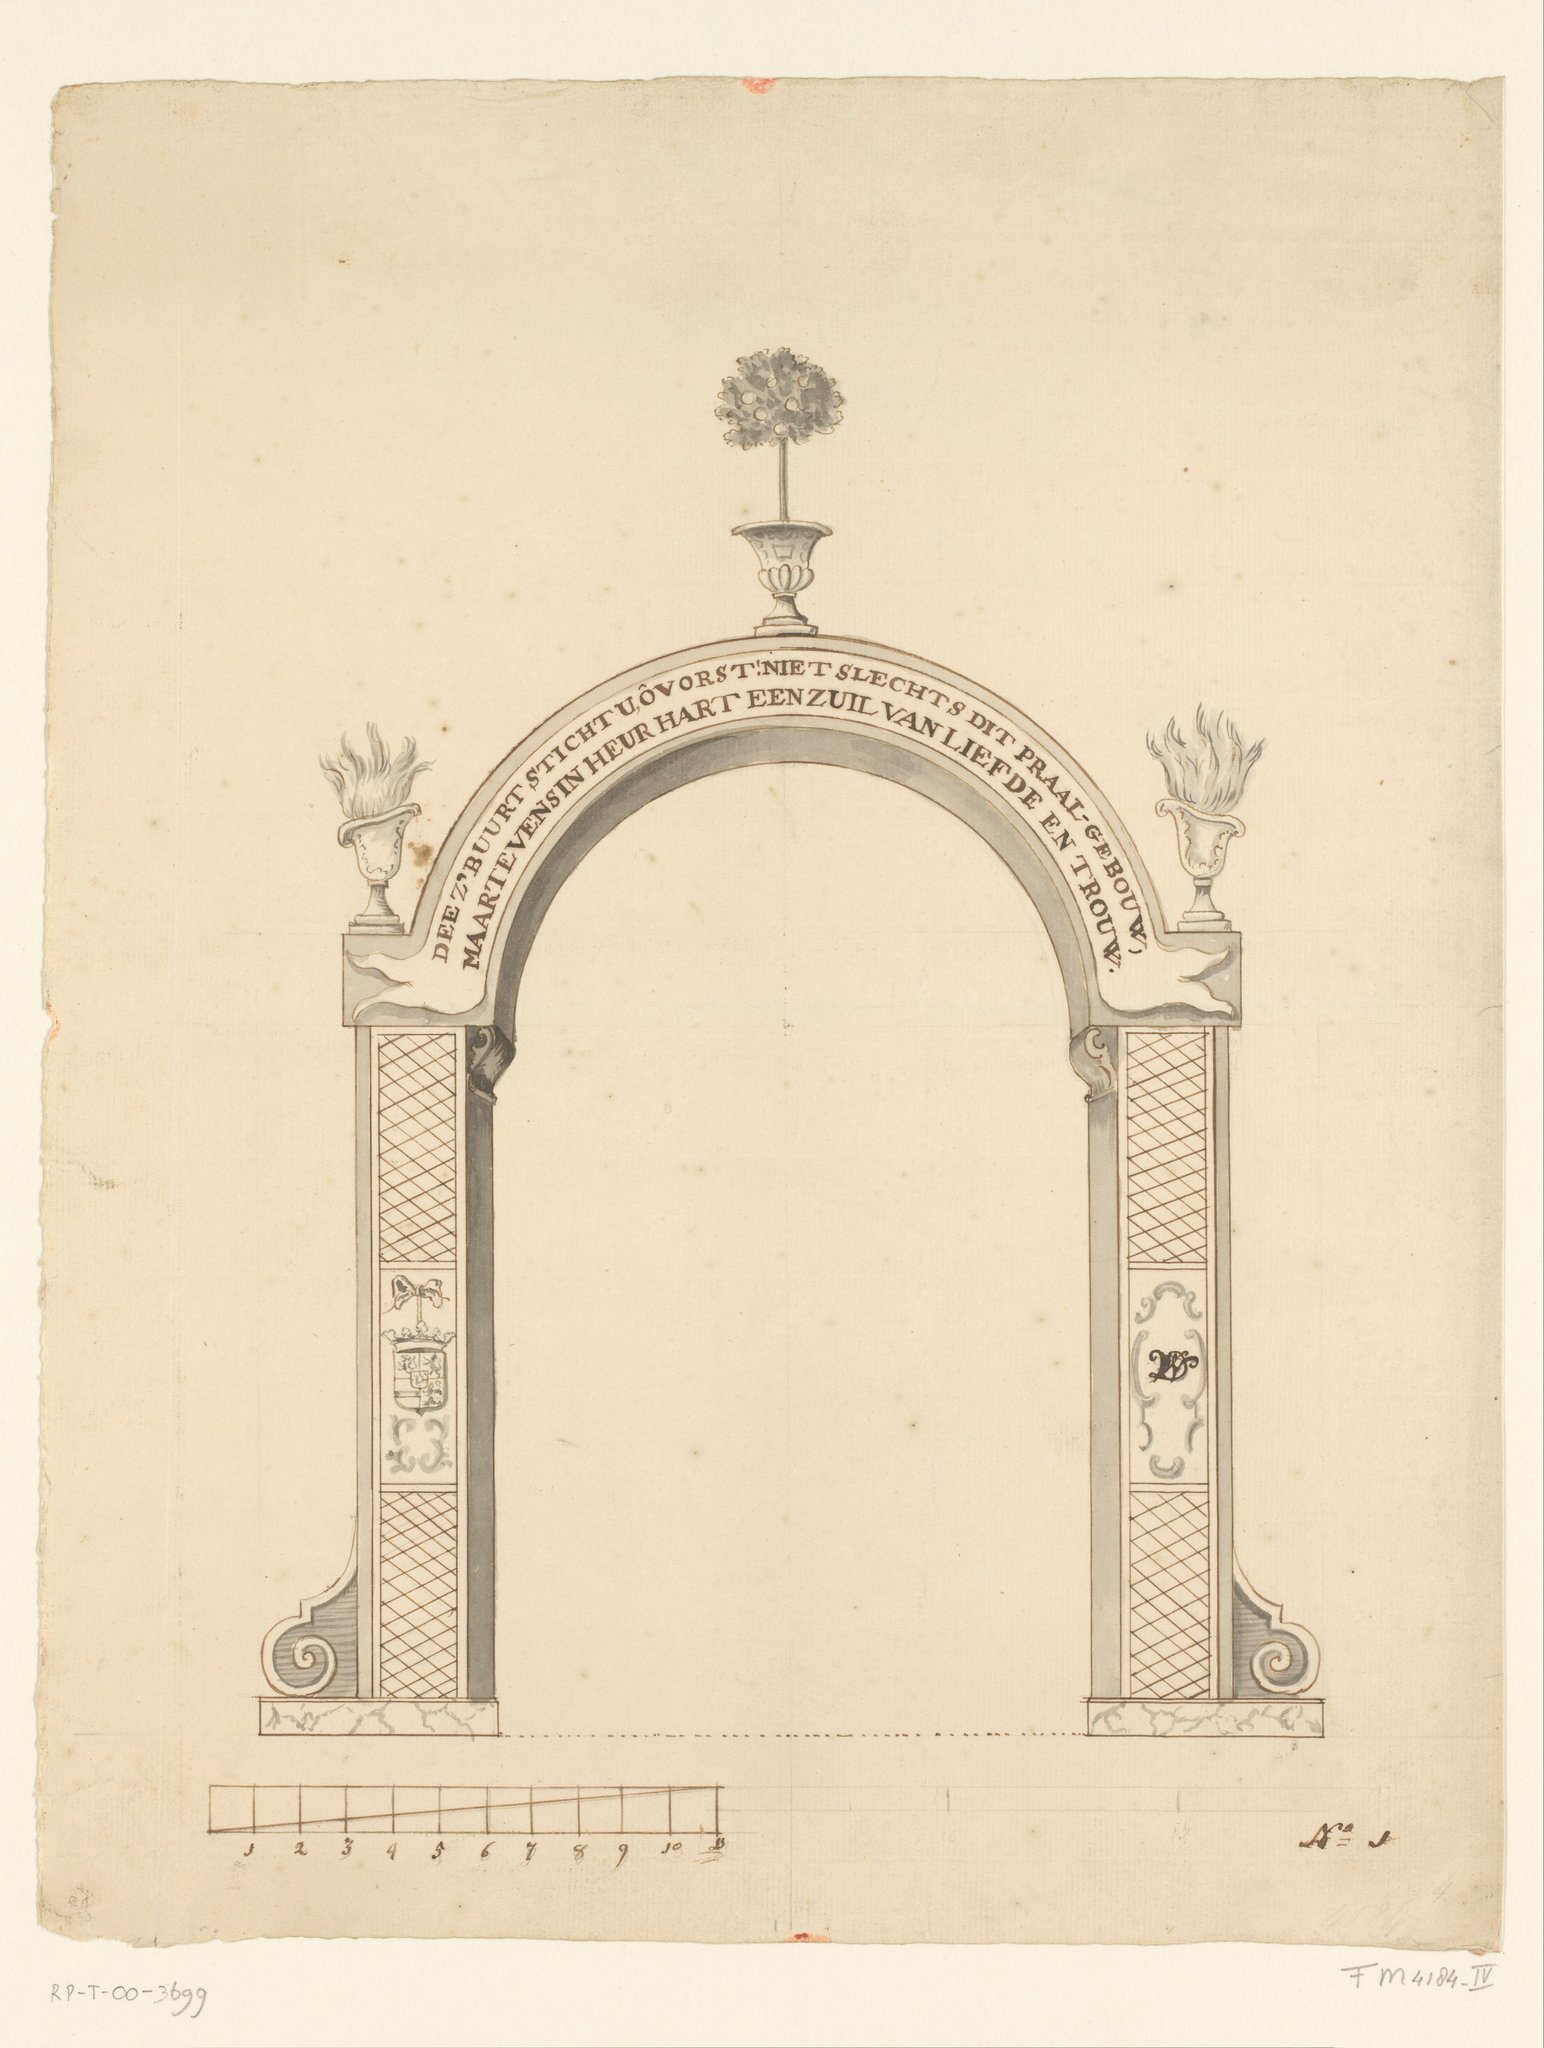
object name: drawing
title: Erepoort te Vlissingen, 1766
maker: Anonymous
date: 1766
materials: paper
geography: northern netherlands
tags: the hague, william v (prince of orange), triumphal arch, flushing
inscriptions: collector's mark: Lugt 2228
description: Erepoort met een Oranjeboom opgericht te Vlissingen ter gelegenheid van de inhuldiging van stadhouder Willem V op 30 mei 1766. Op de boog de tekst: Deez' Buurt Sticht U, ô Vorst ... etc. Gemerkt rechtsonder: No. 1.